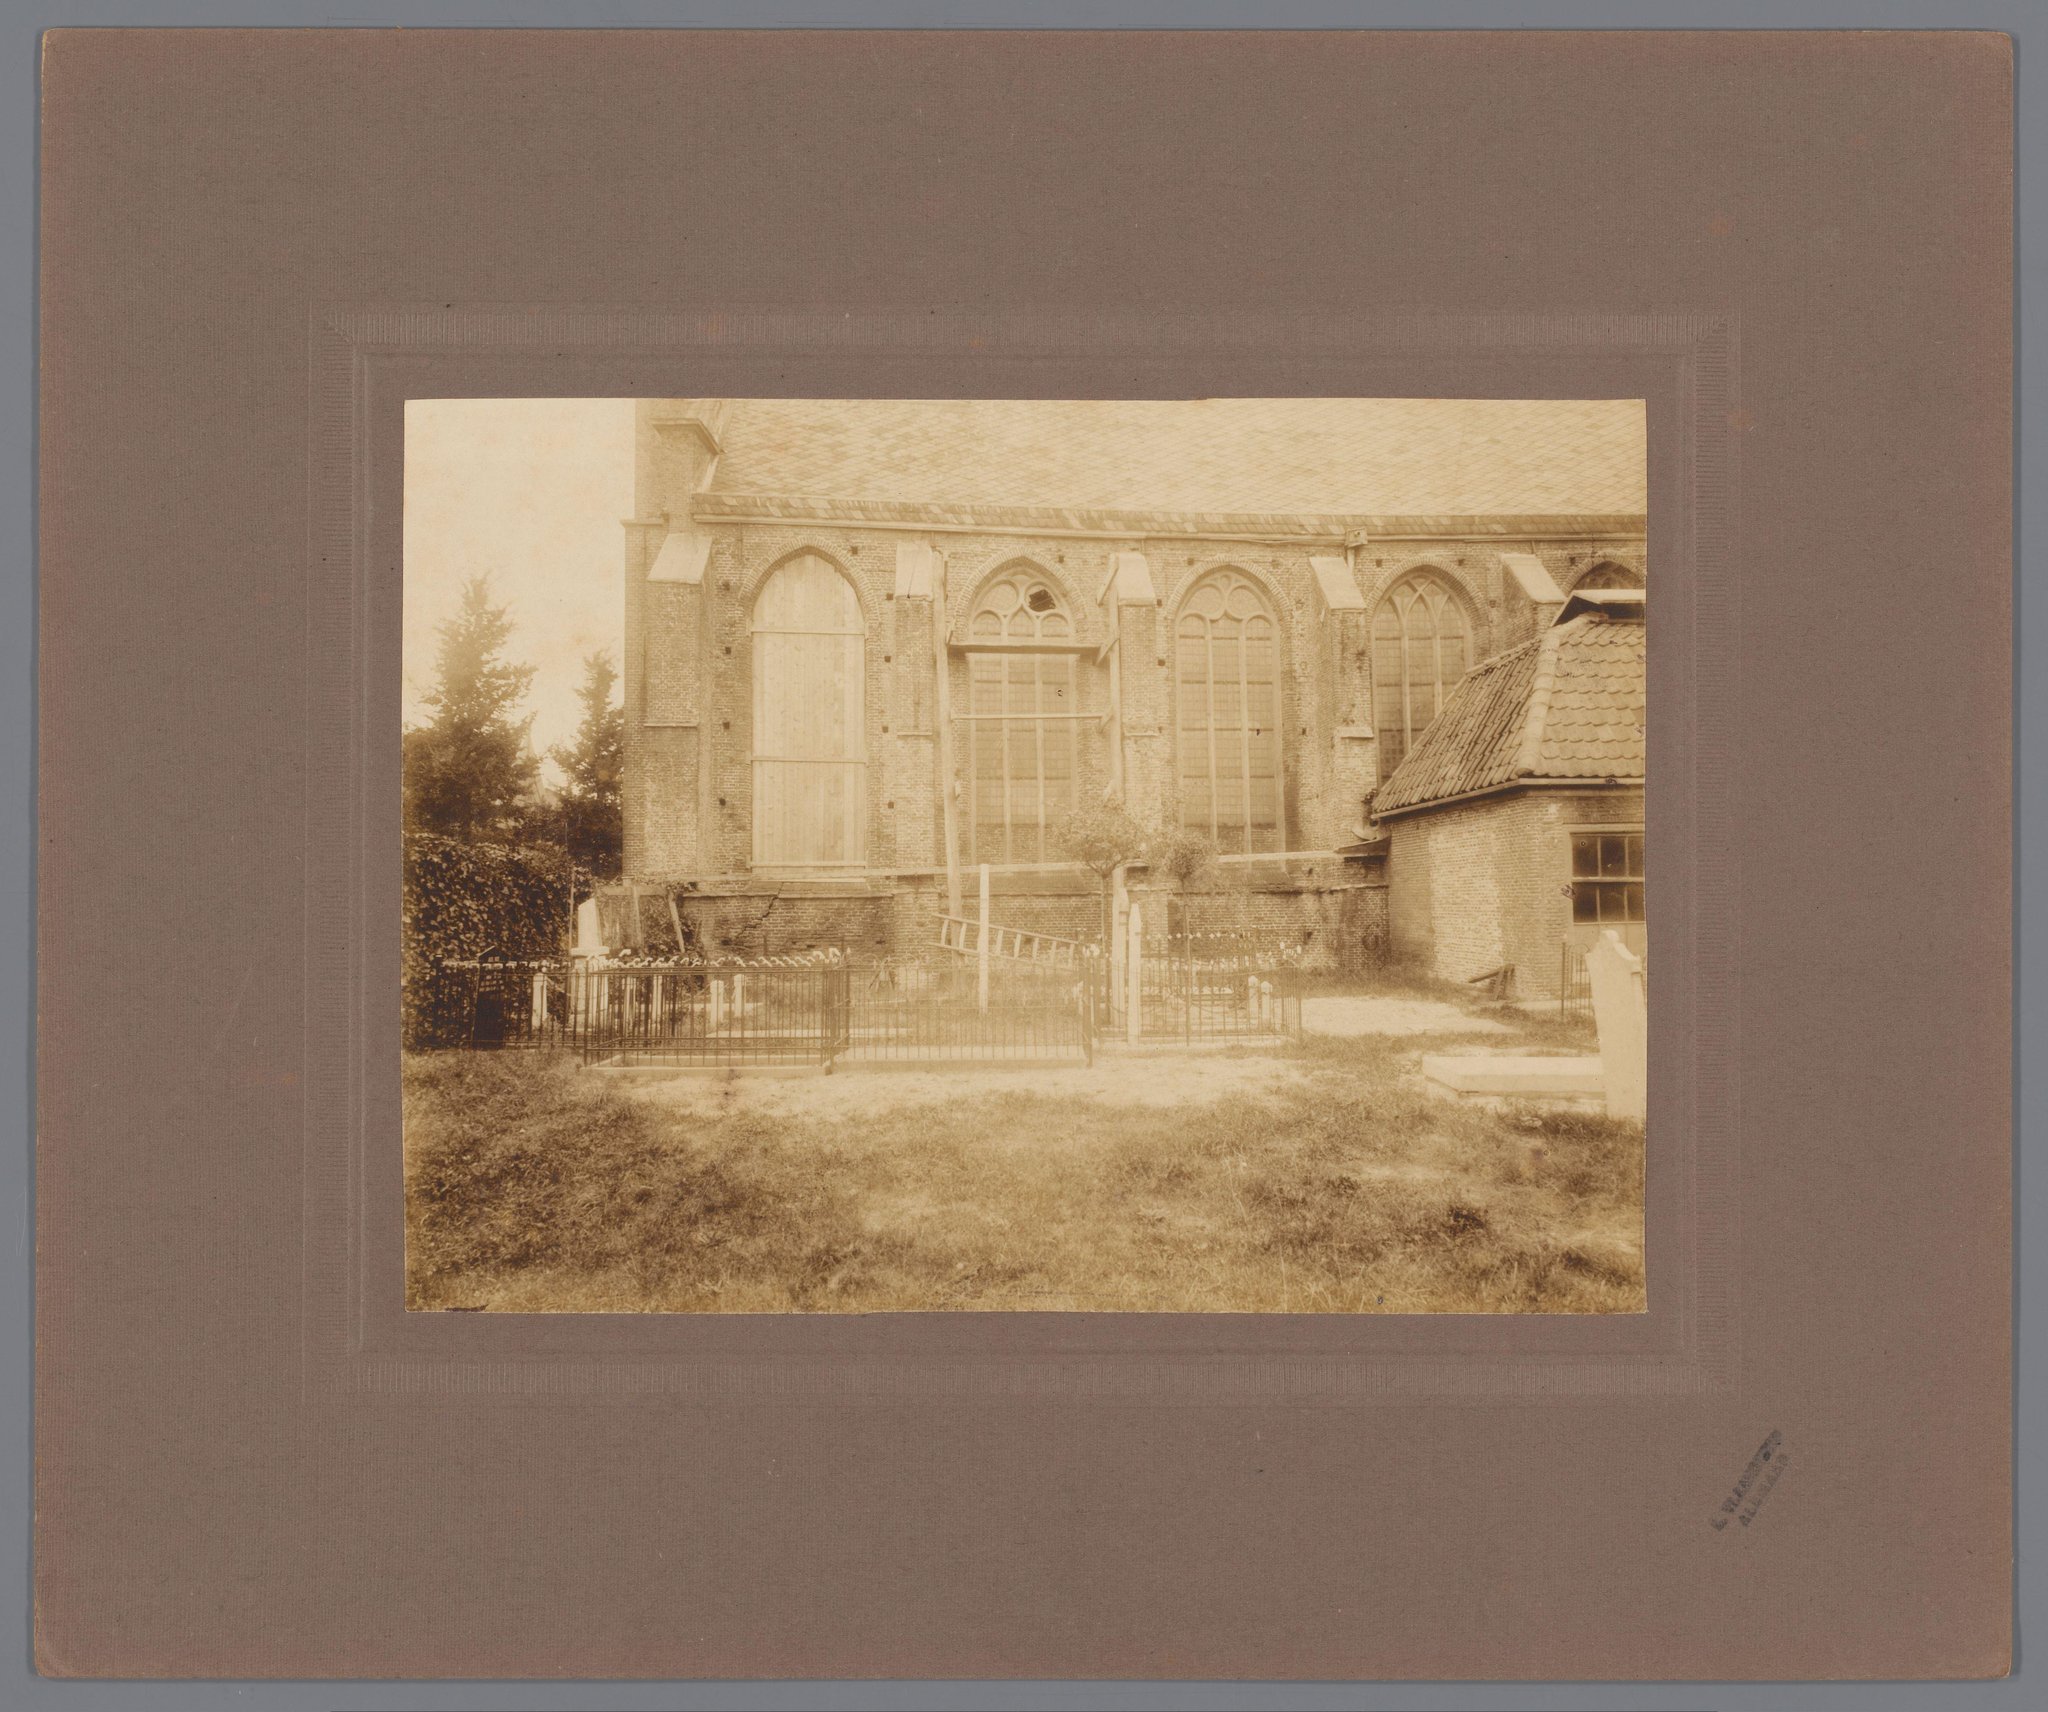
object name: photograph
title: Aanzicht op kerk in De Rijp, Noord-Holland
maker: leonard vlaanderen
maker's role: fotograaf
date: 1921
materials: cardboard, photographic support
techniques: gelatin silver print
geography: alkmaar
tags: de rijp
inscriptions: date, annotation: ‘De Rijp 1921’, stamp: ‘L. Vlaanderen//Alkmaar’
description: Aanzicht op zijkant kerk in De Rijp, Noord-Holland, met een stuk grasveld, een hek, een ladder, en rechts in beeld een huis voor de kerk gebouwd.